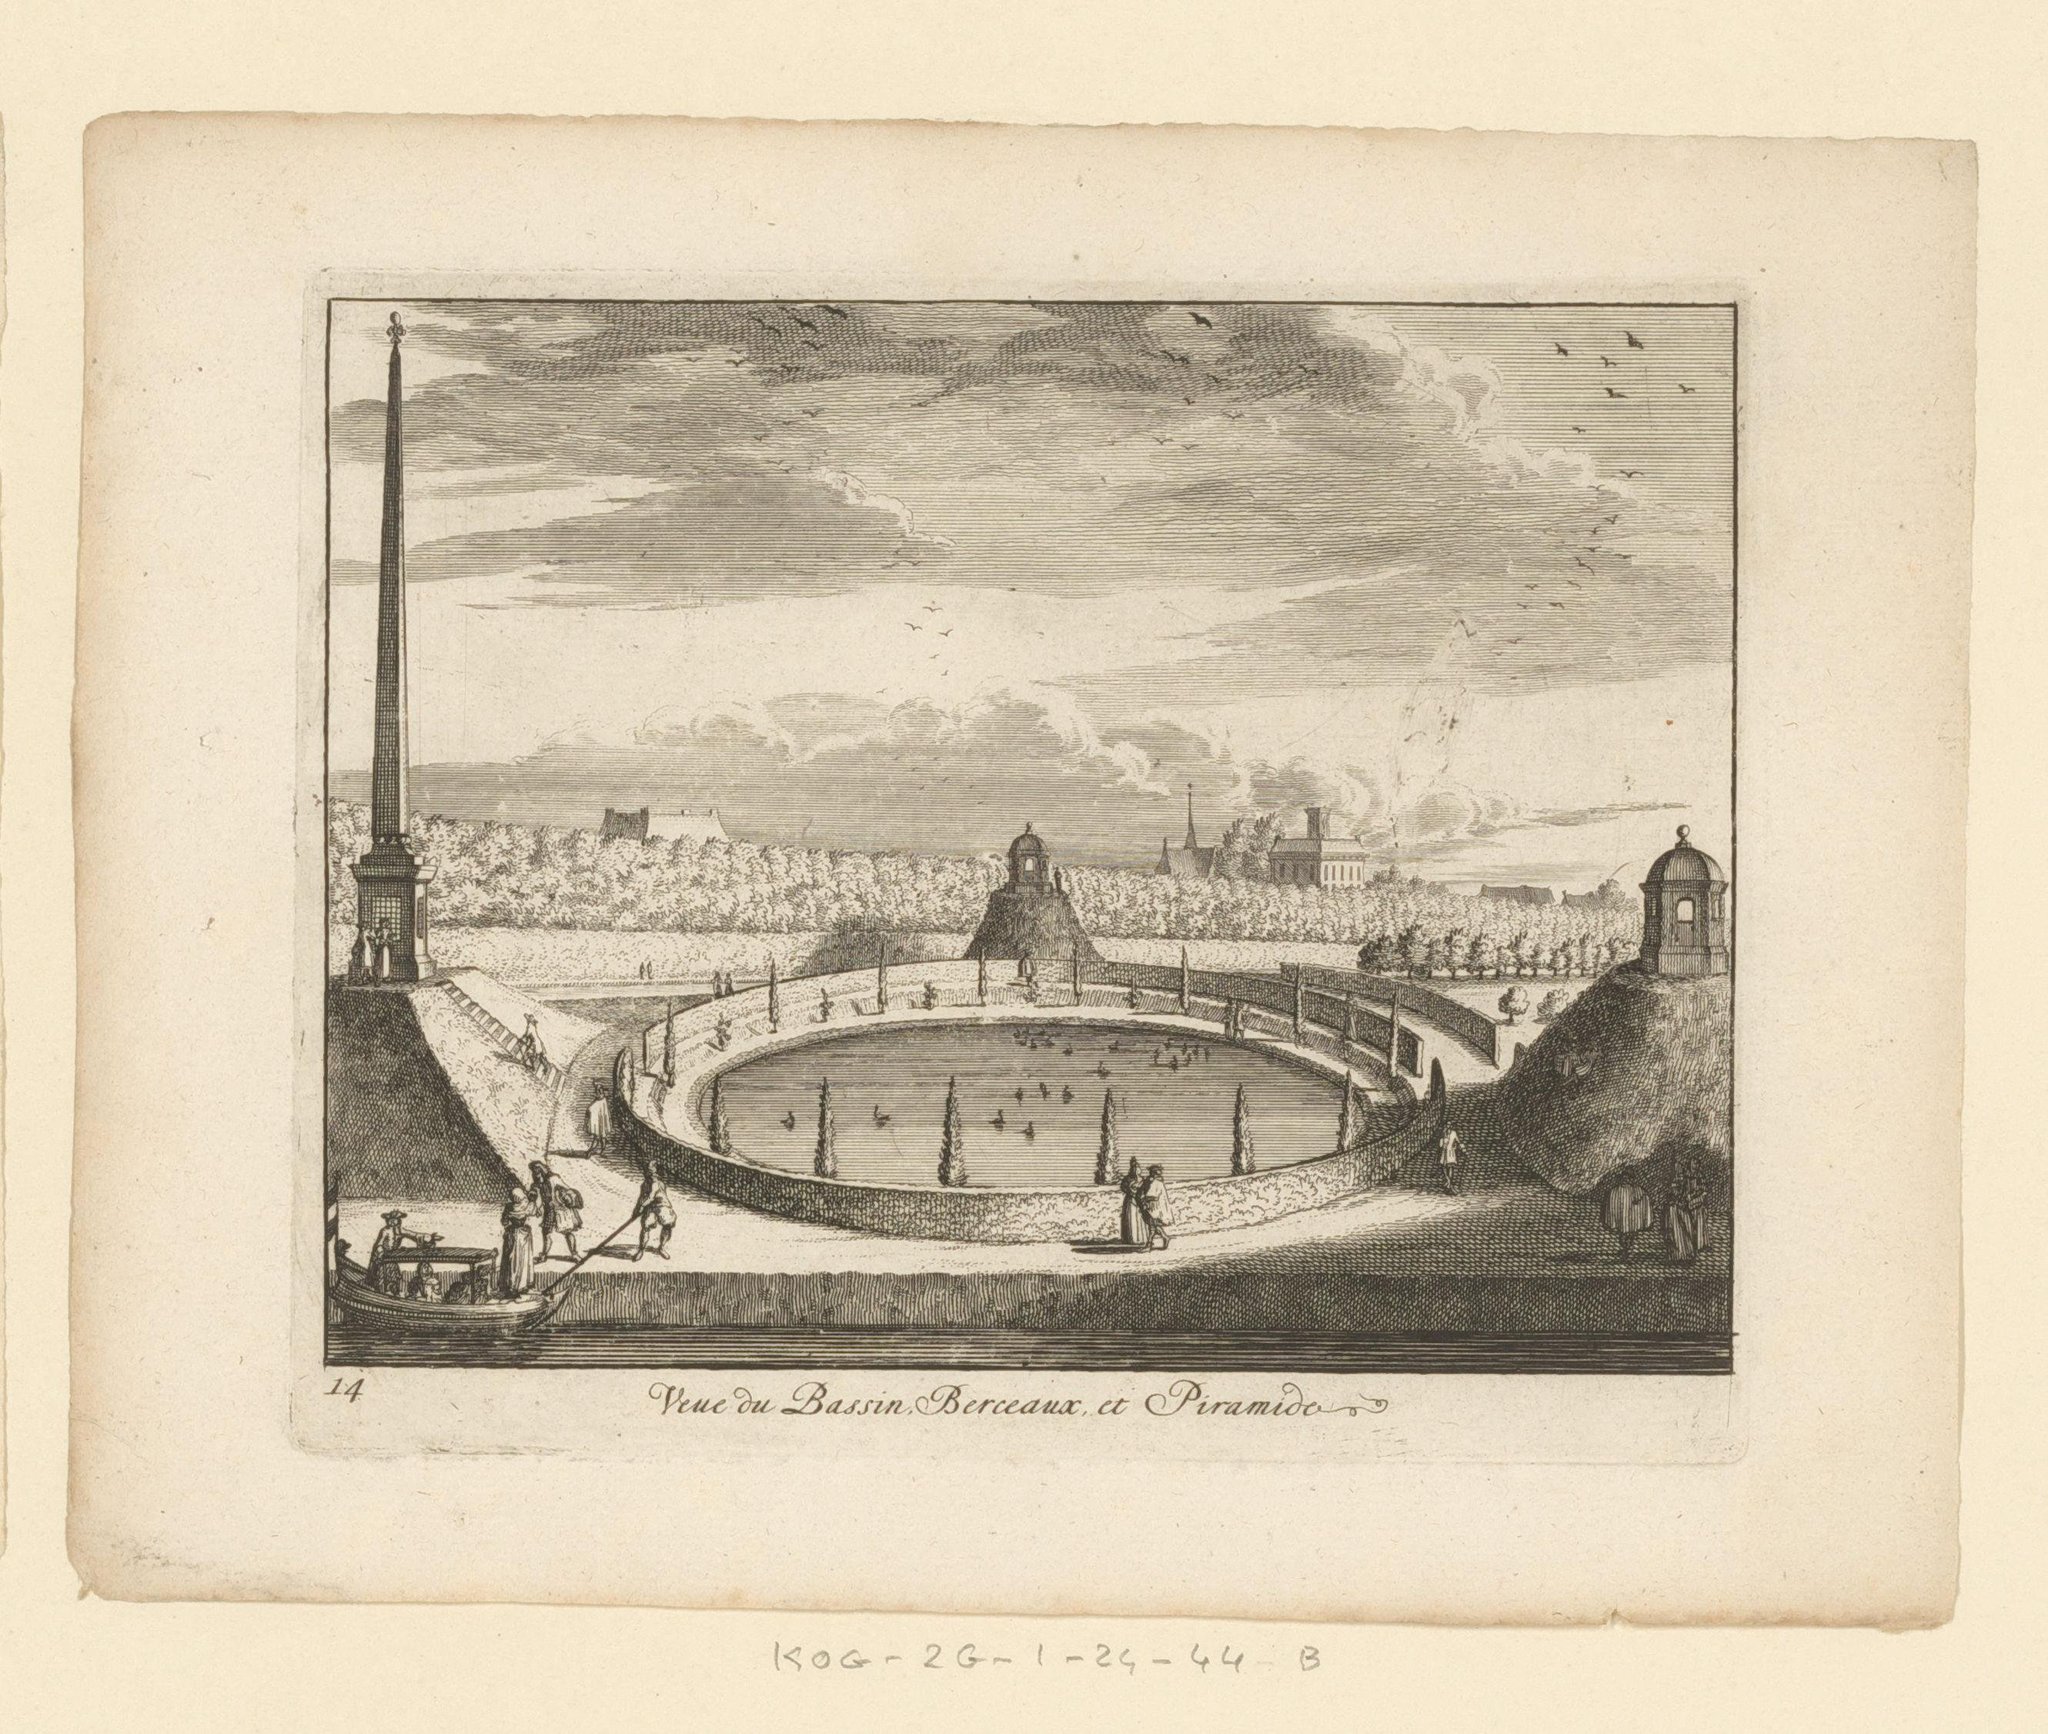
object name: print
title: Veue du Bassin Berceaux et Piramide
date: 1721-1774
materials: paper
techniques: engraving, etching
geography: amsterdam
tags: magdalena poulle, obelisks (garden ornaments), garden pond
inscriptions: stamp, collector's mark: Lugt 1641, stamp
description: De vijver en de obelisk in de tuin van Kasteel Gunterstein te Breukelen. Op de voorgrond figuren in en bij een trekschuit. Linksonder genummerd: 14. Onderwerpsrubrieken binnen de Atlas Zeden en Gewoonten: Zeden en Gewoonten in Engeren Zin, De Woning. Kastelen en buitenplaatsen. Utrecht (vervolg.).